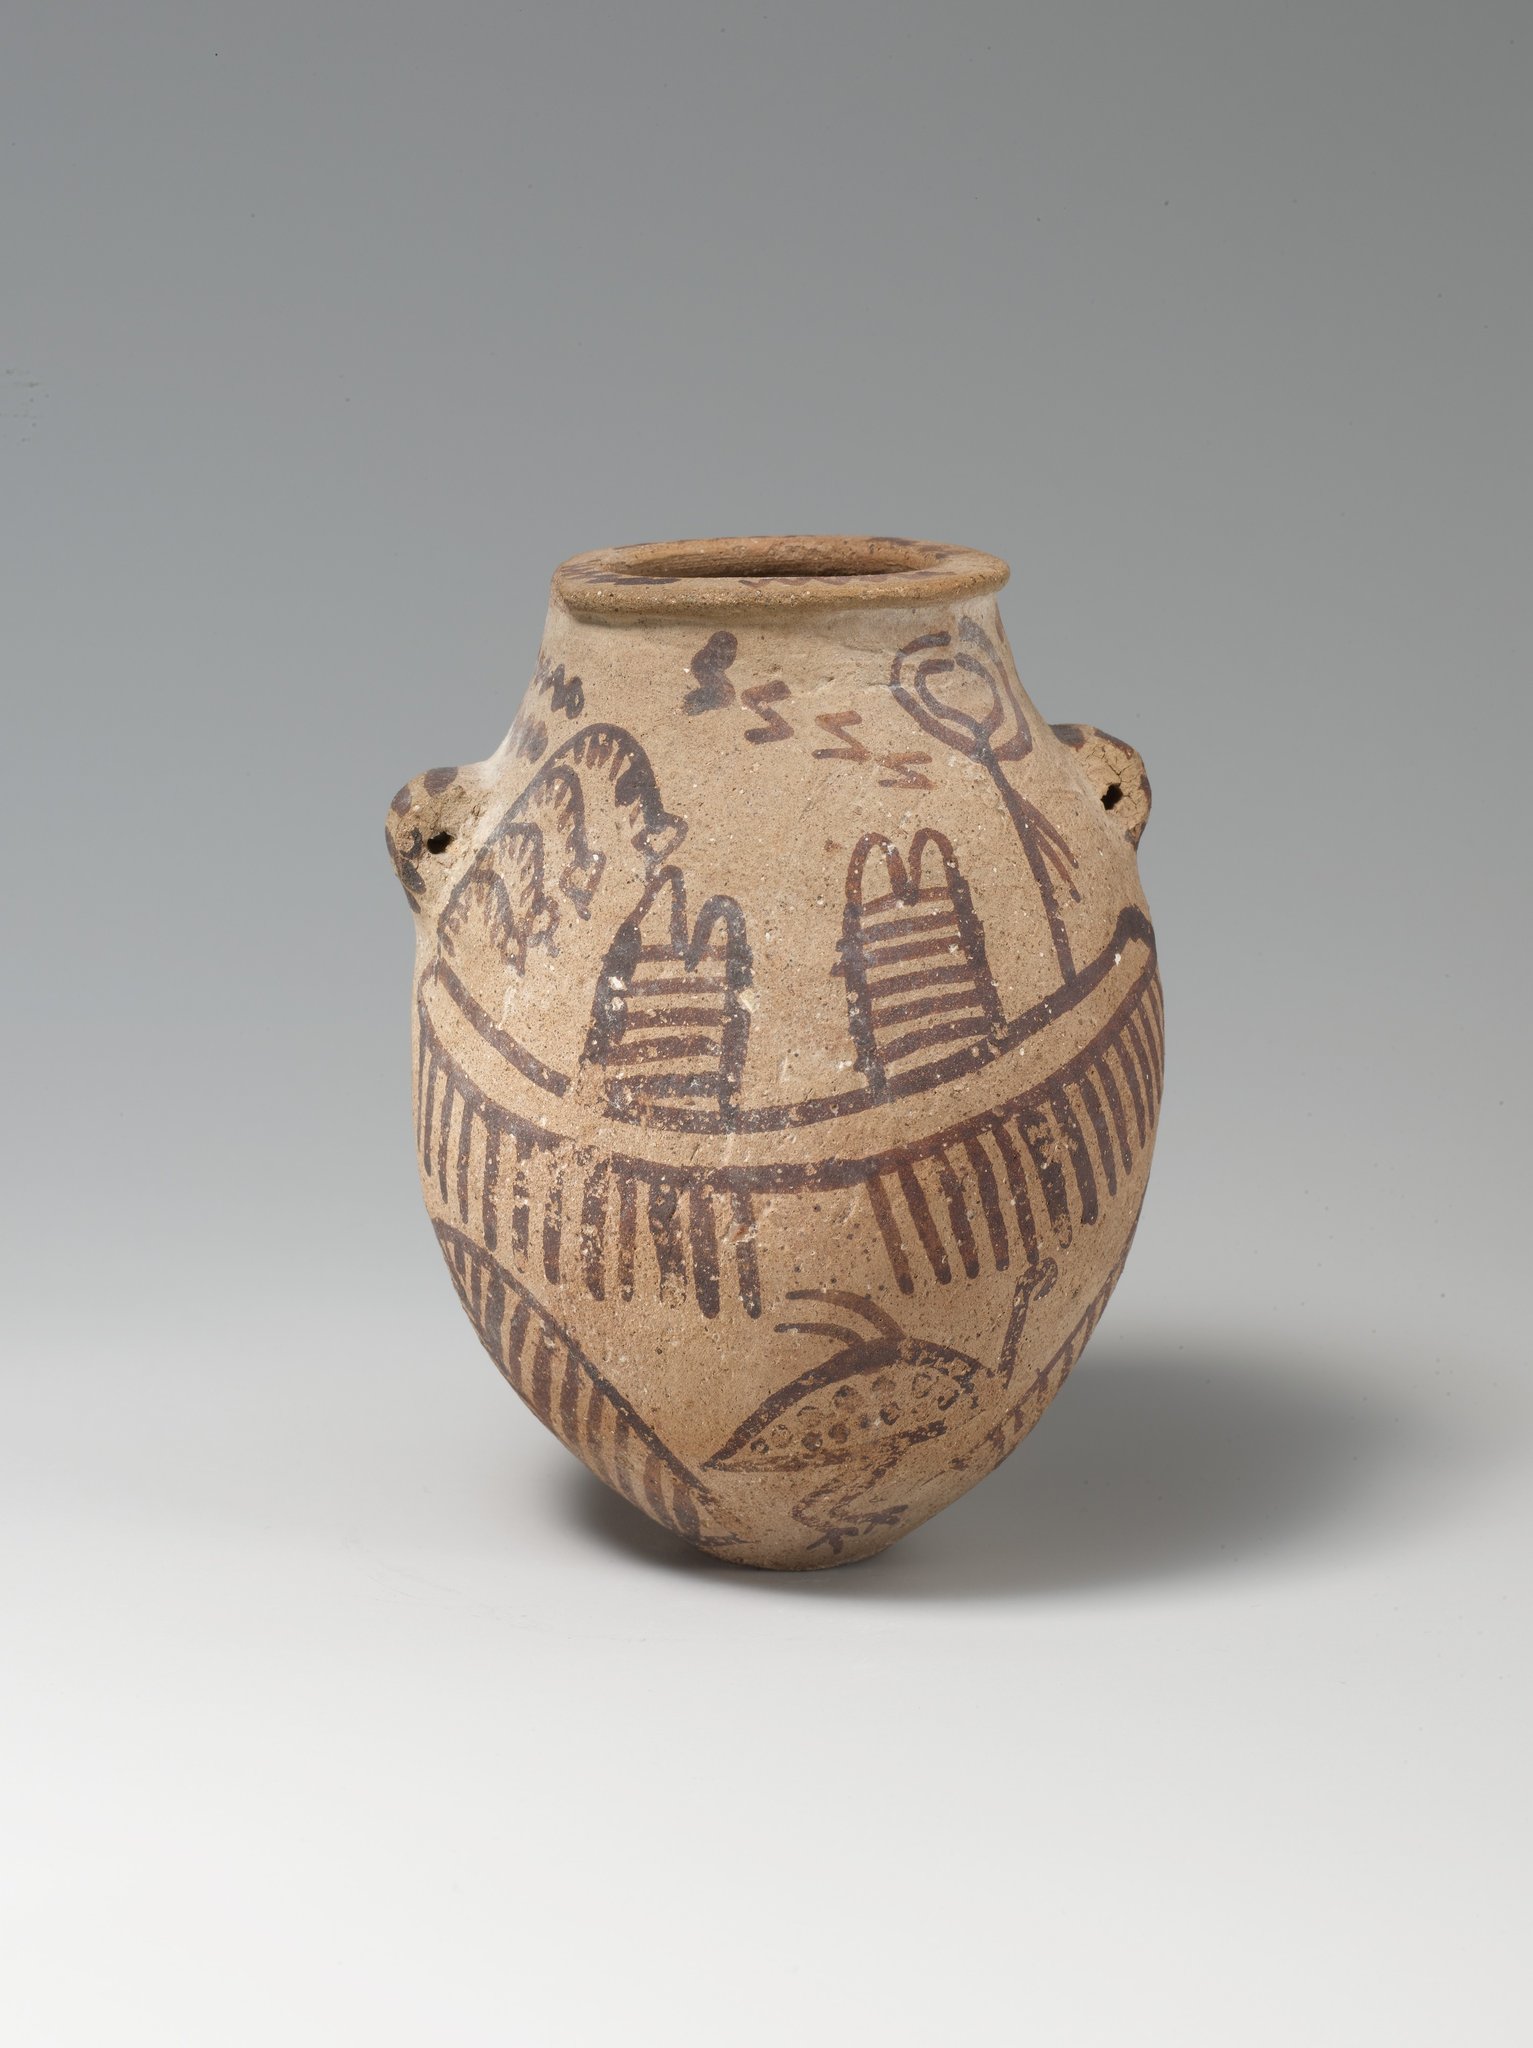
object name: jar, decorated ware, boat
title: Jar Decorated with Boats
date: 3450-3350 BCE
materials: paint, pottery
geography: egypt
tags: birds